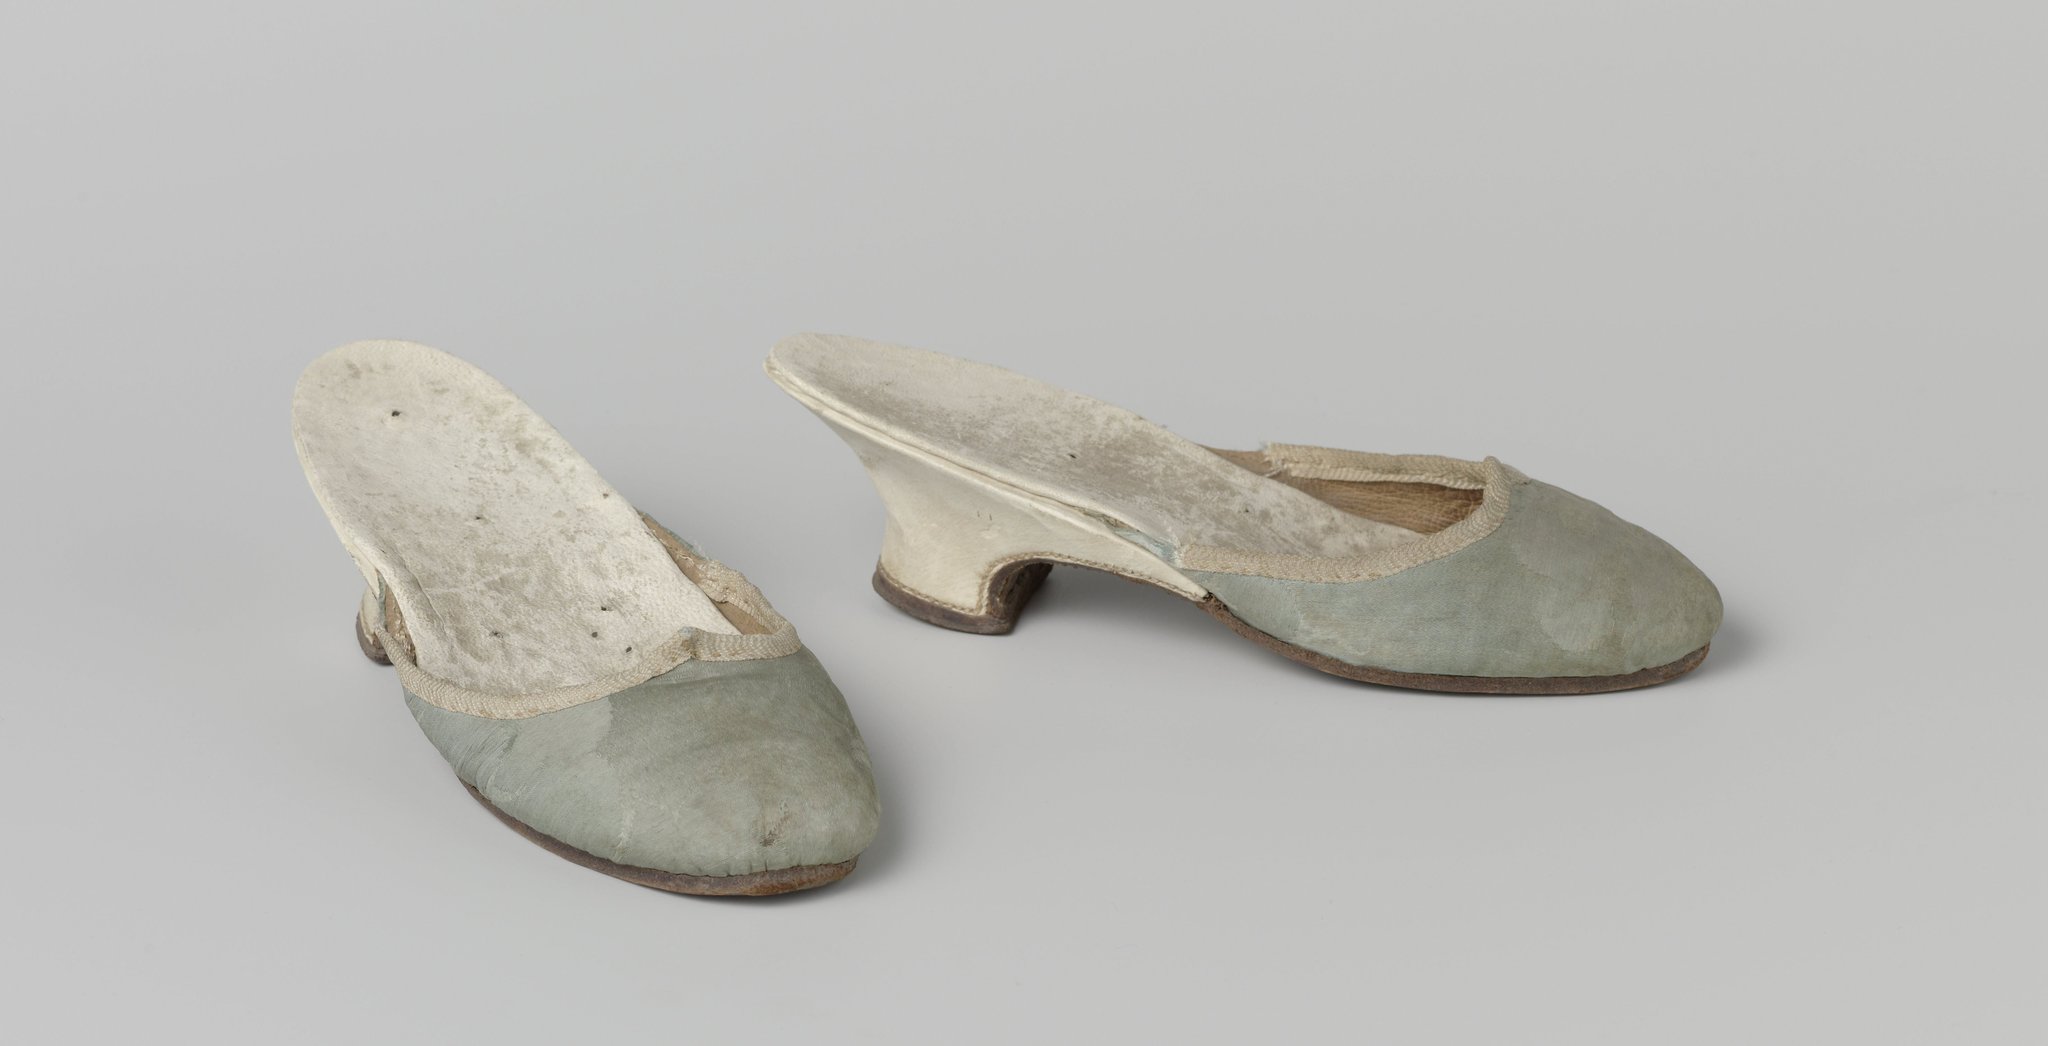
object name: womenswear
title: Damesmuiltje met voorblad van blauwe zijdendamast, binnenzool en hak overtrokken met wit glacéleer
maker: Anonymous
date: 1750-1800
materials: silk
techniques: weave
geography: netherlands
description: Damesmuiltje met voorblad van blauwe zijdendamast, binnenzool en hak overtrokken met wit glacéleer.